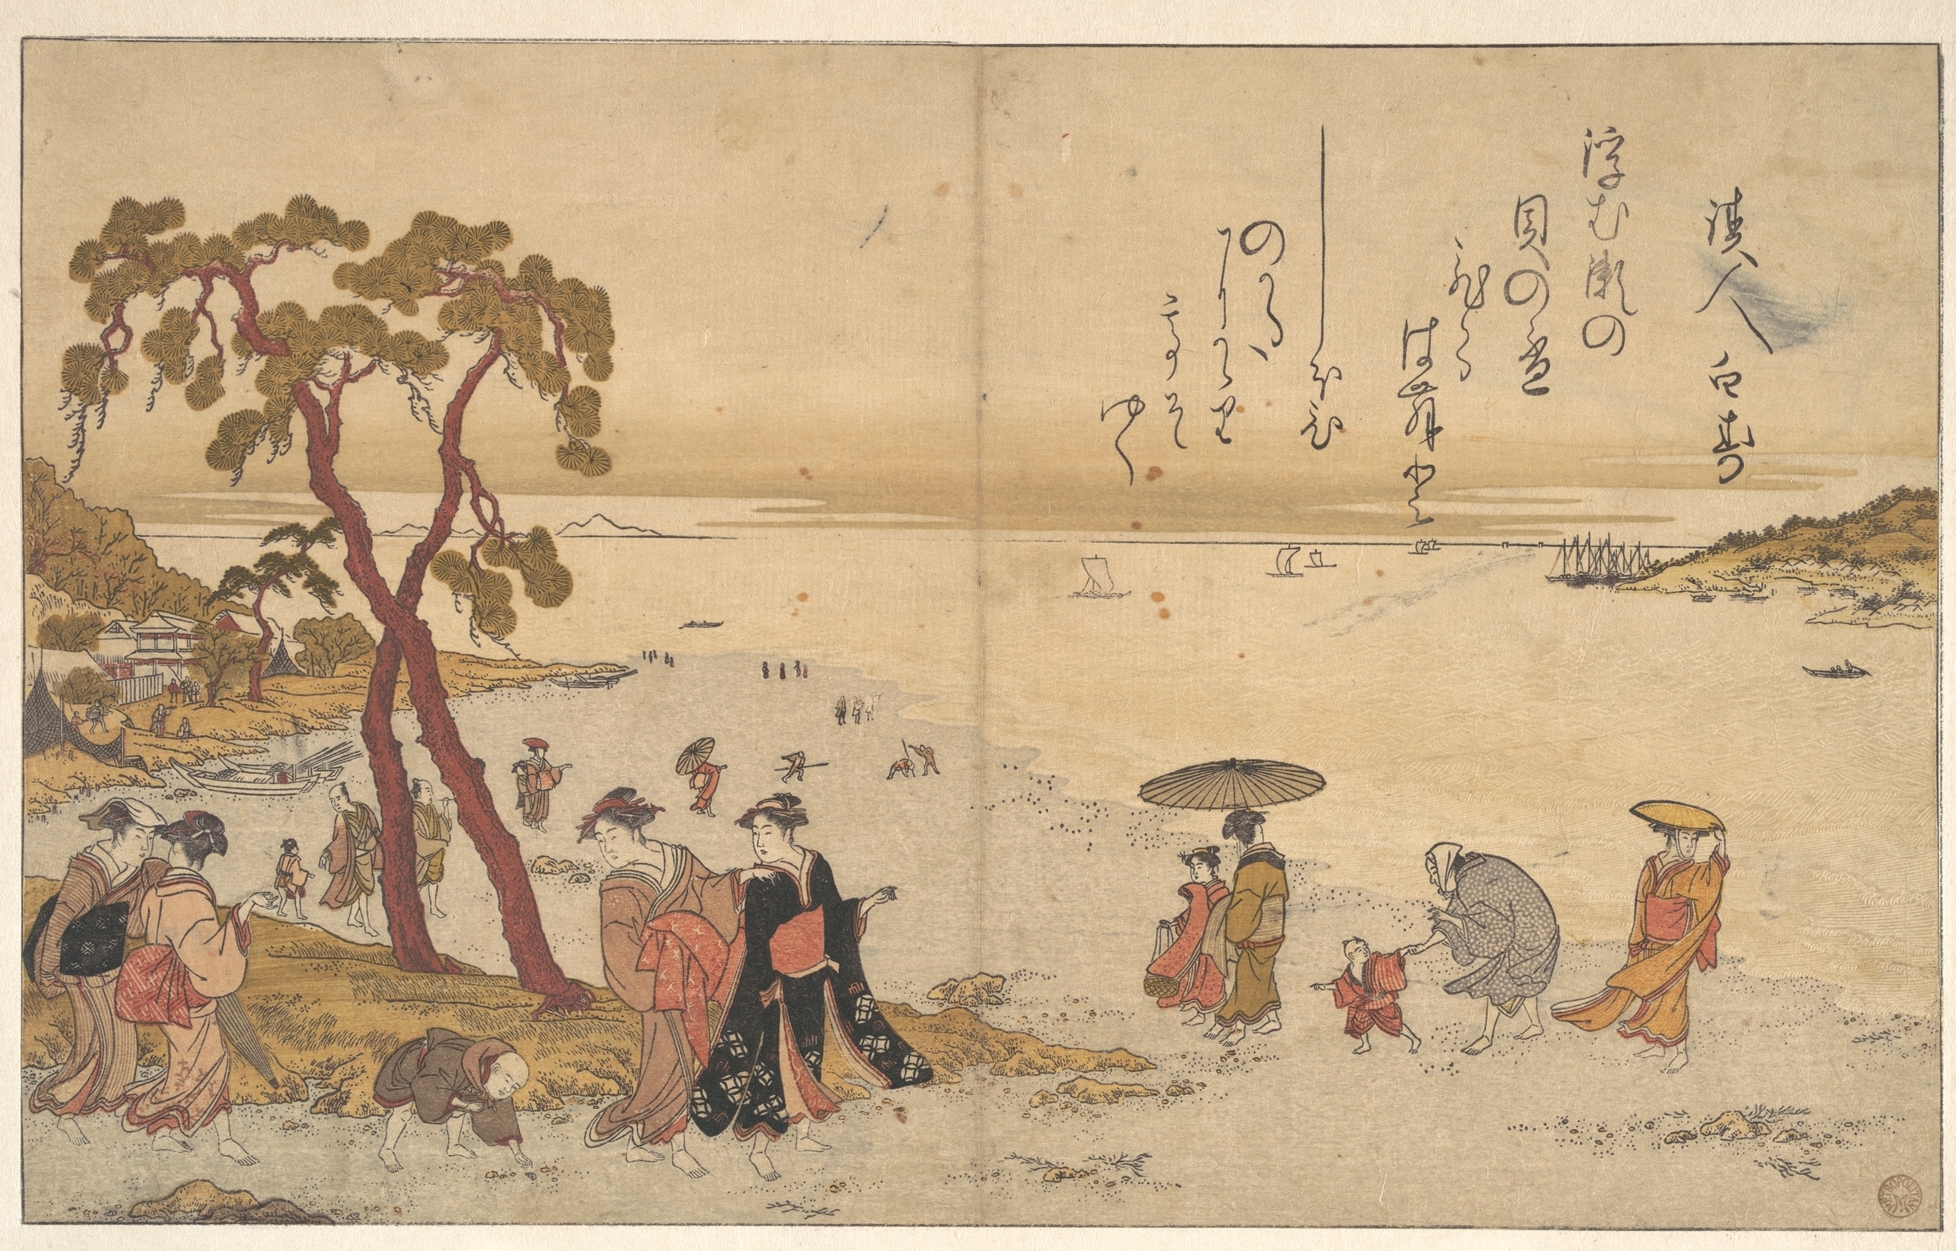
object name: print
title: Girls Gathering Shells on the Sea-shore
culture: japanese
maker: kitagawa utamaro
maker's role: artist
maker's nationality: japanese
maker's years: 1754-1806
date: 1790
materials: ink, paper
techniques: woodblock print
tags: children,women,beaches